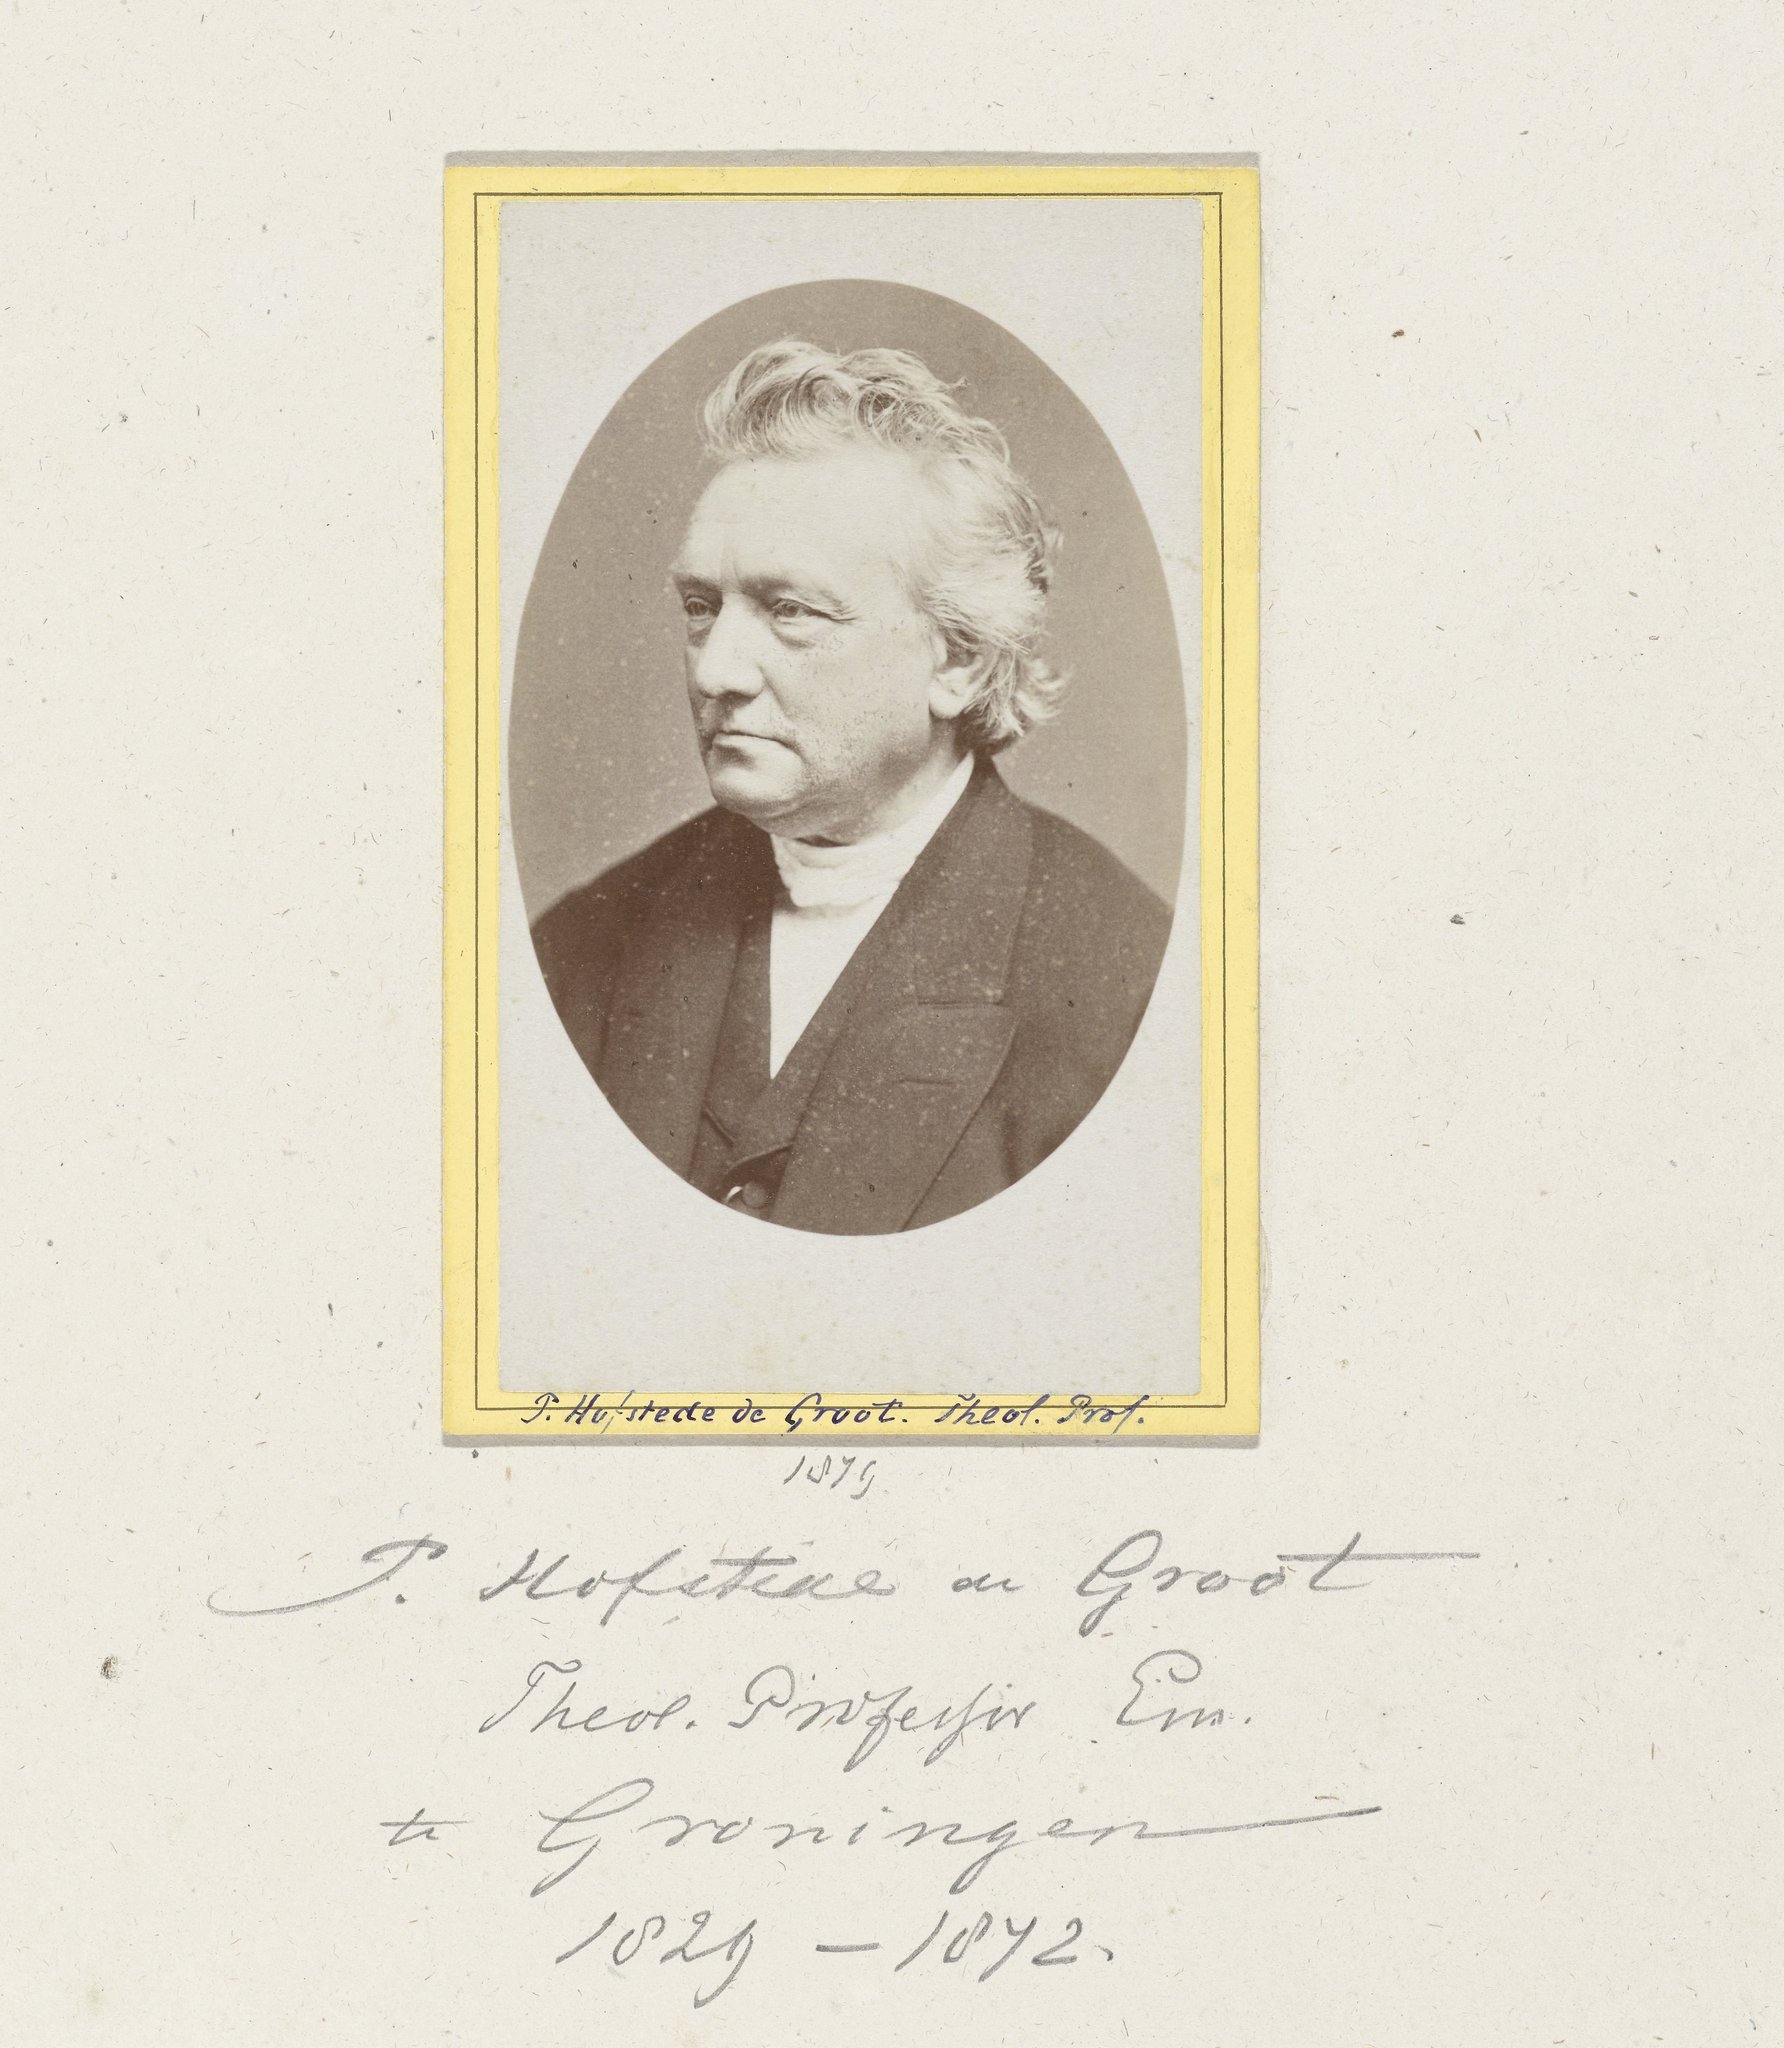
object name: carte de visite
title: P. Hofstede de Groot, theol. prof. em te Groningen 1829-1872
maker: Anonymous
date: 1860-1872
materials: paper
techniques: albumen print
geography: netherlands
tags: historical persons (portraits and scenes from the life)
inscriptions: name: ‘P. Hofstede de Groot, theol. prof. em te Groningen 1829-1872’